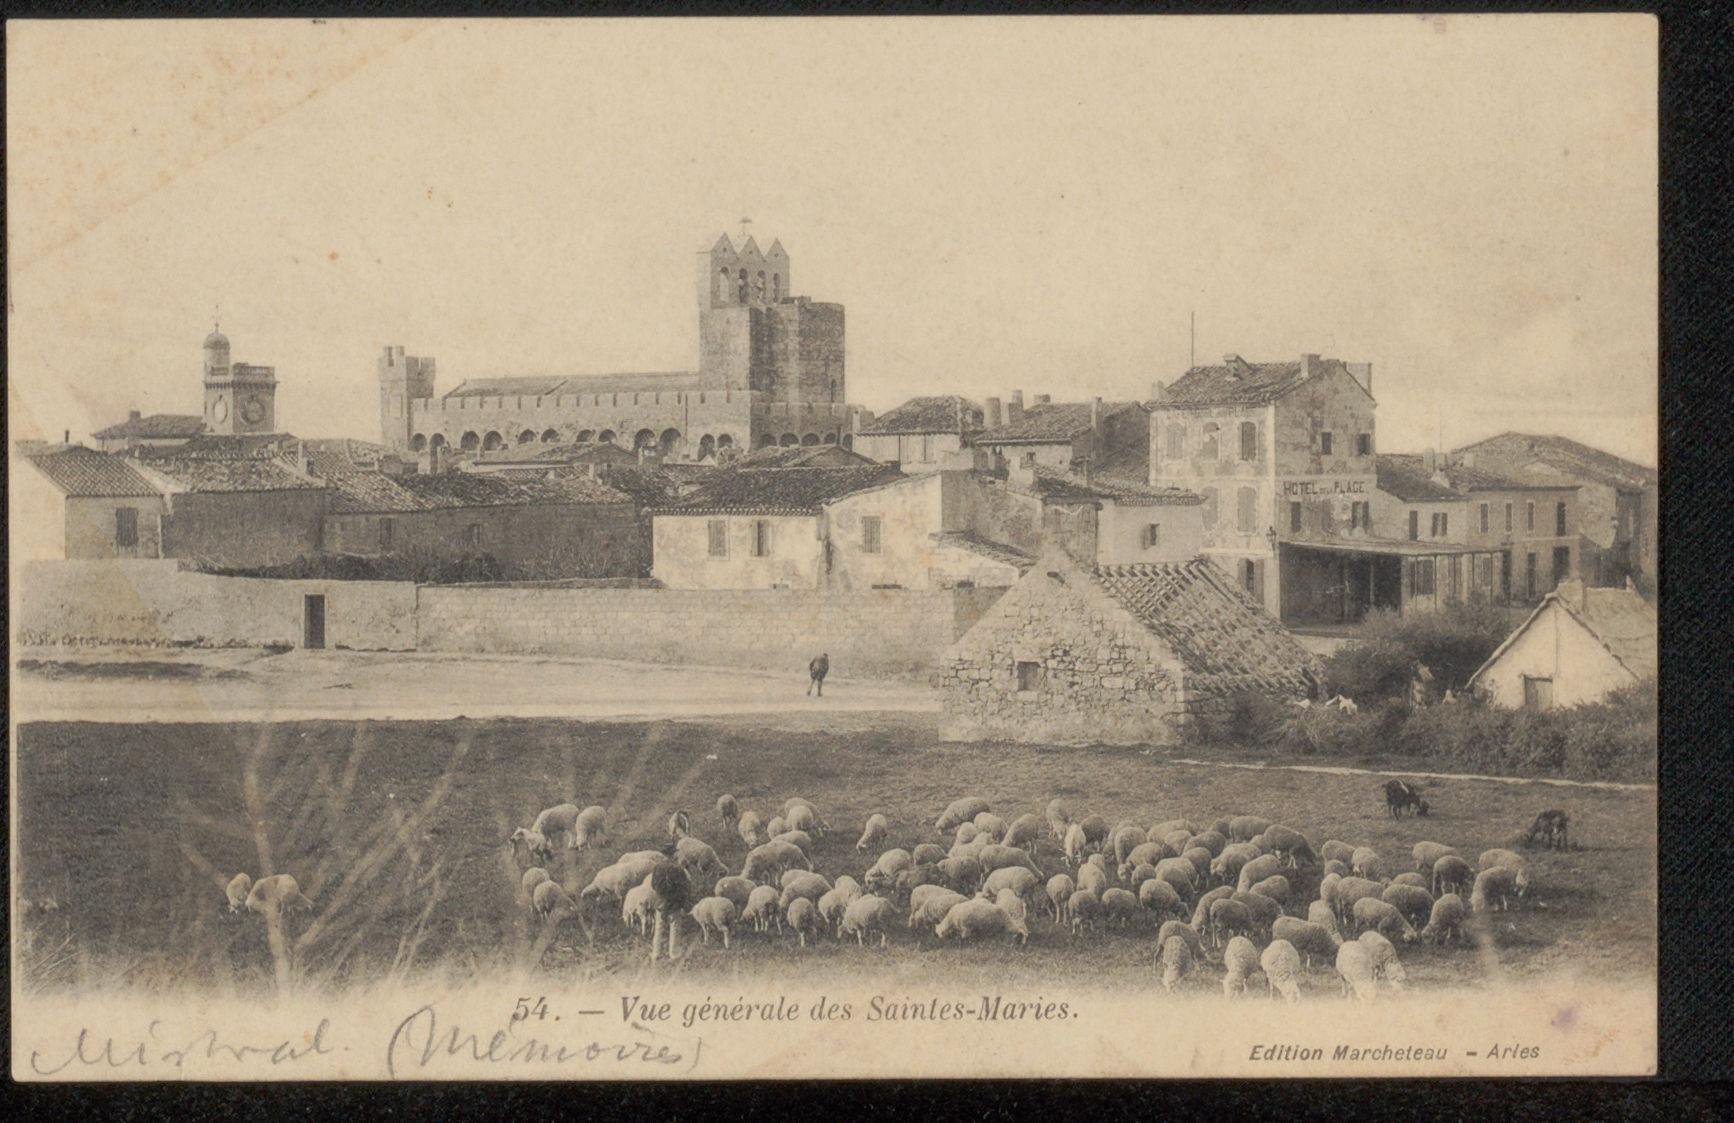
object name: print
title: Prent uit archief Philip Zilcken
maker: marcheteau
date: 1867-1930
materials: ink, paper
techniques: photograph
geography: arles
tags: the hague, painter, draughtsman, philip zilcken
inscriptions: collector's mark: ‘RPK’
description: Prent is vermoedelijk deel geweest van een prentbriefkaart.